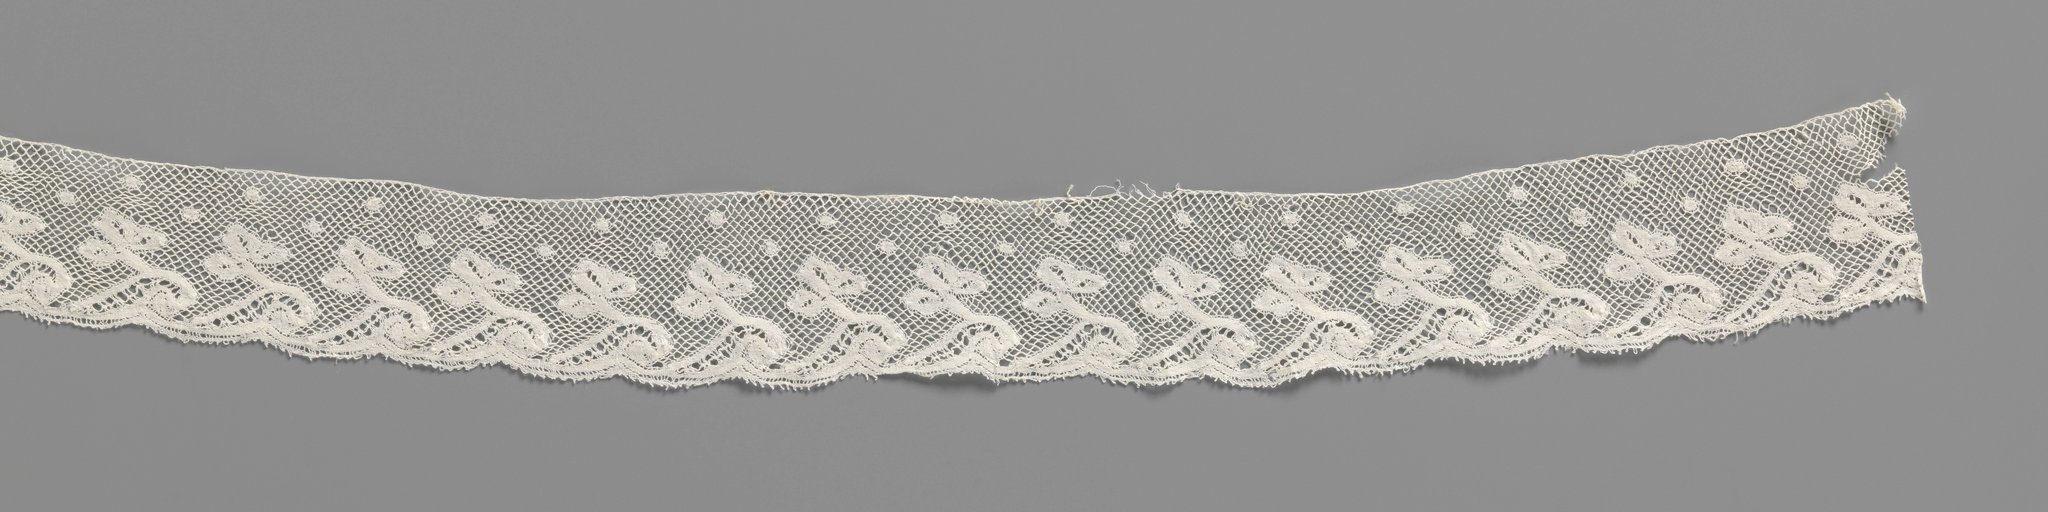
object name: strip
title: Strook kloskant met drieblad op golf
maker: Anonymous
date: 1920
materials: linen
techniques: lace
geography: netherlands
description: Strook naturelkleurige kloskant: Valenciennes-kant. Op een met enkele moesjes versierde traliegrond, een vierkante Valenciennes-grond, staat een lopend patroon van een drieblad, uitkomende uit de top van een golf. Een gladde lijst vult de gerekte schulpen. De strook bestaat uit vier aan elkaar genaaide delen.